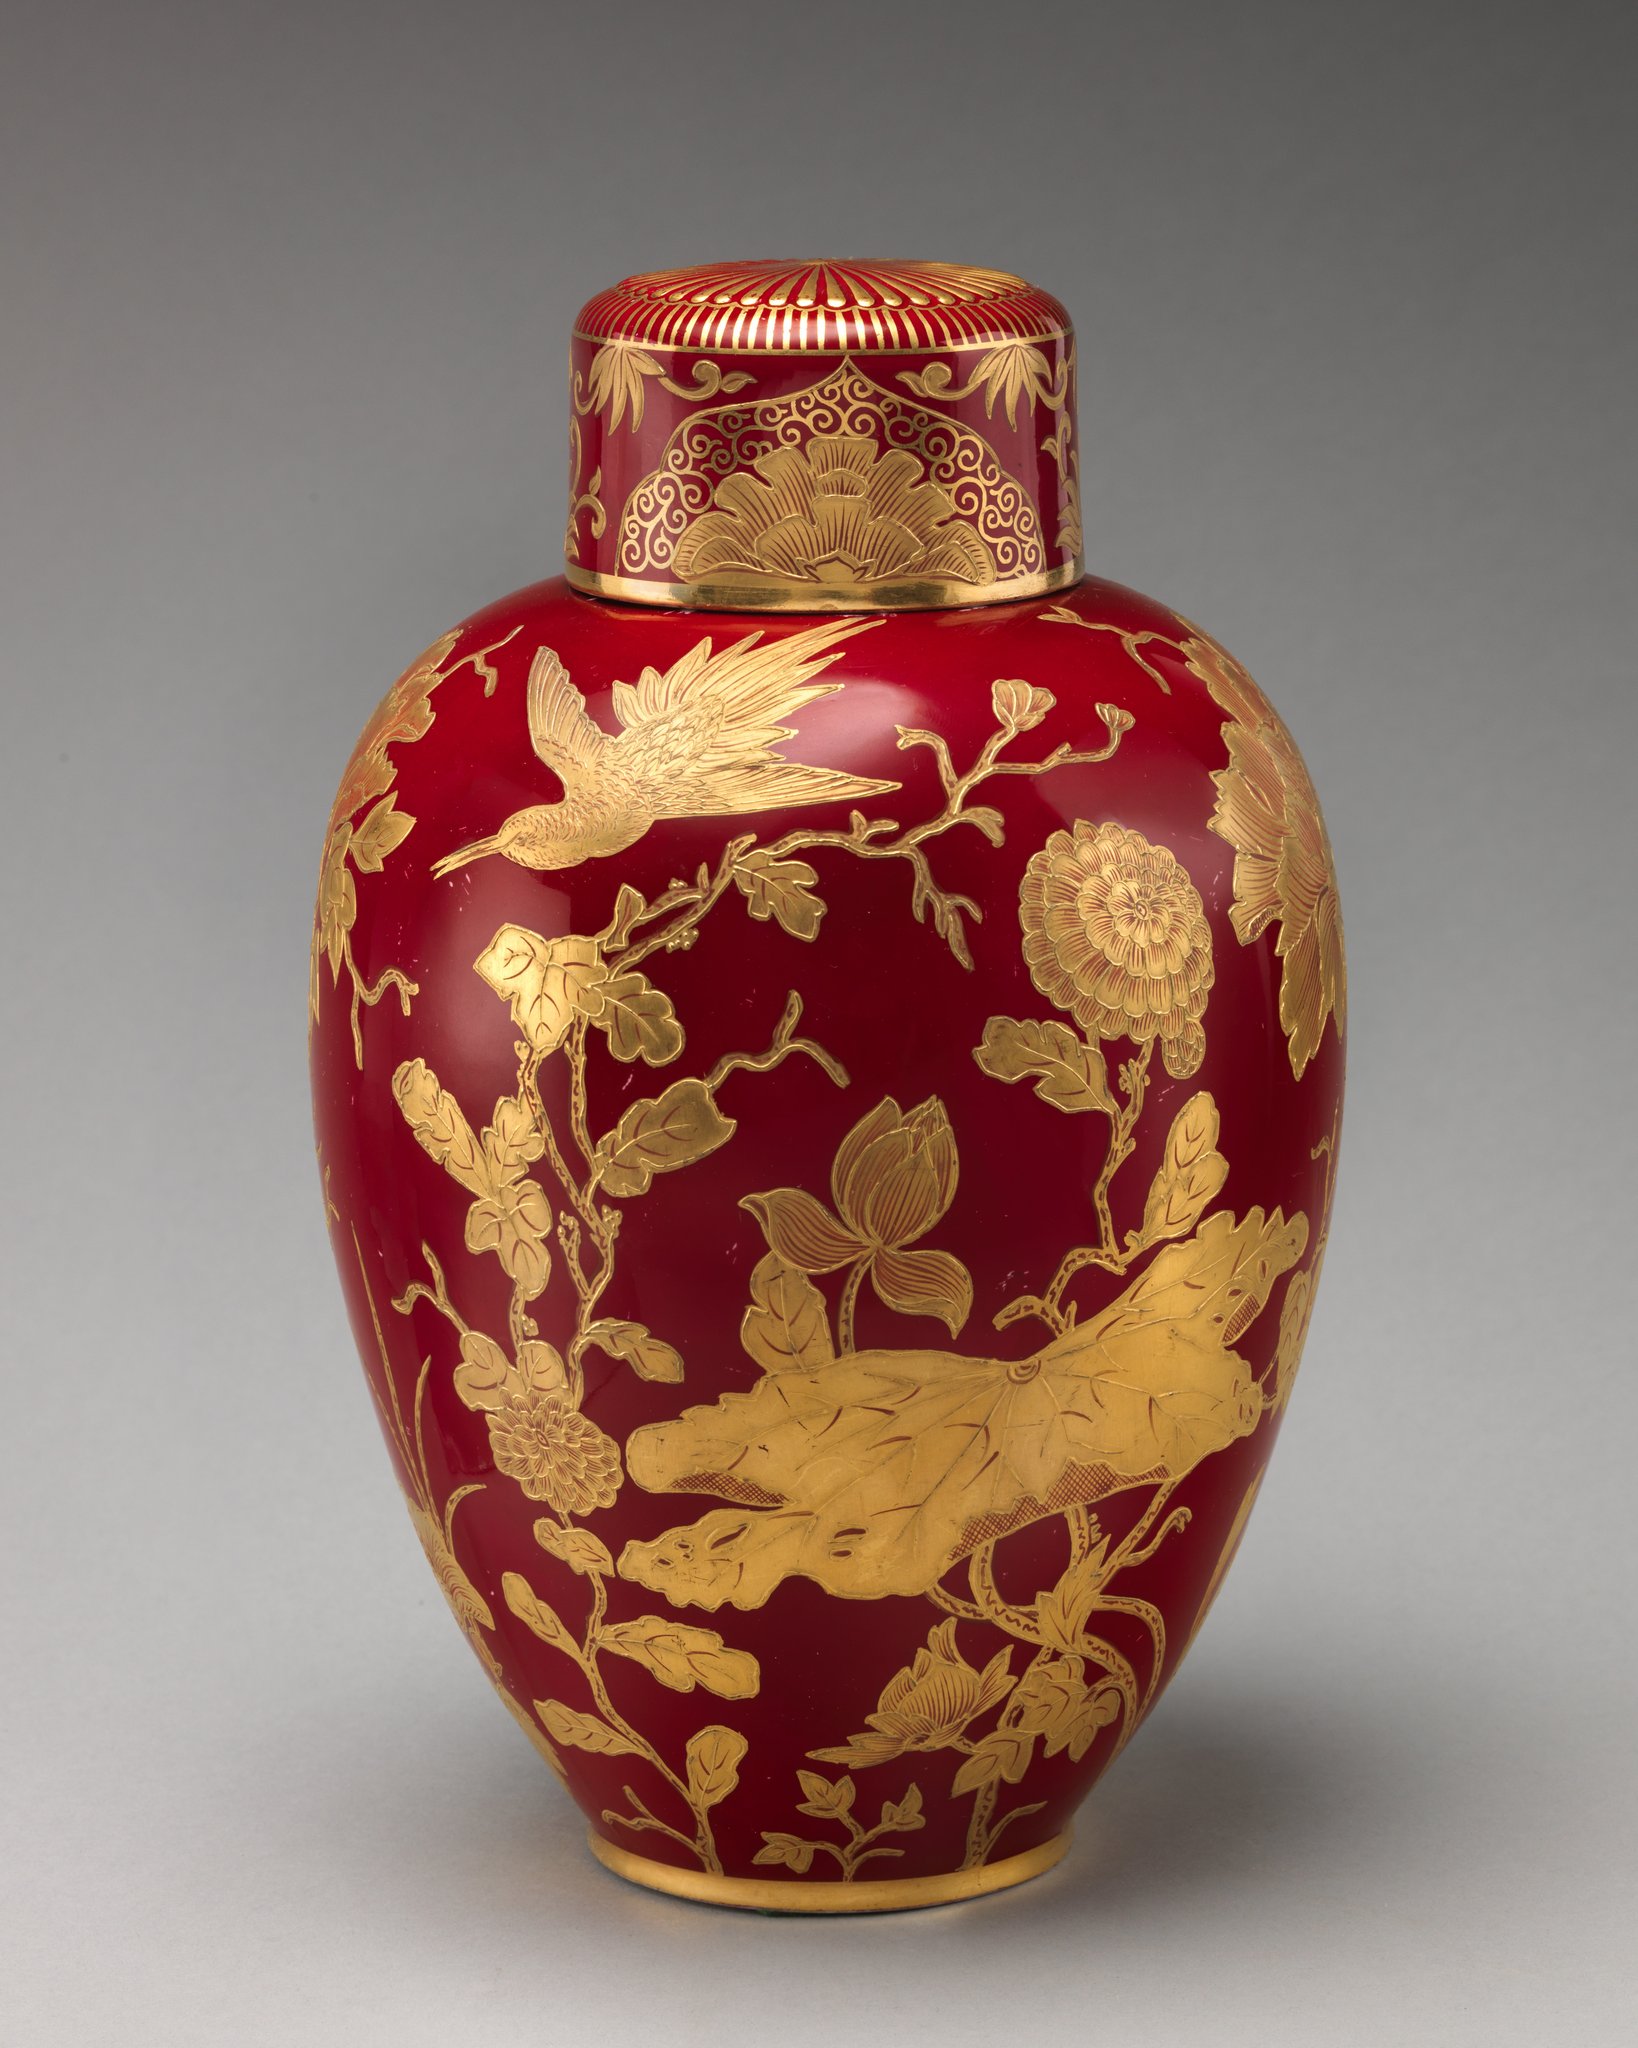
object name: ginger jar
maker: crown derby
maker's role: maker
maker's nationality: british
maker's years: 1750-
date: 1886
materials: porcelain